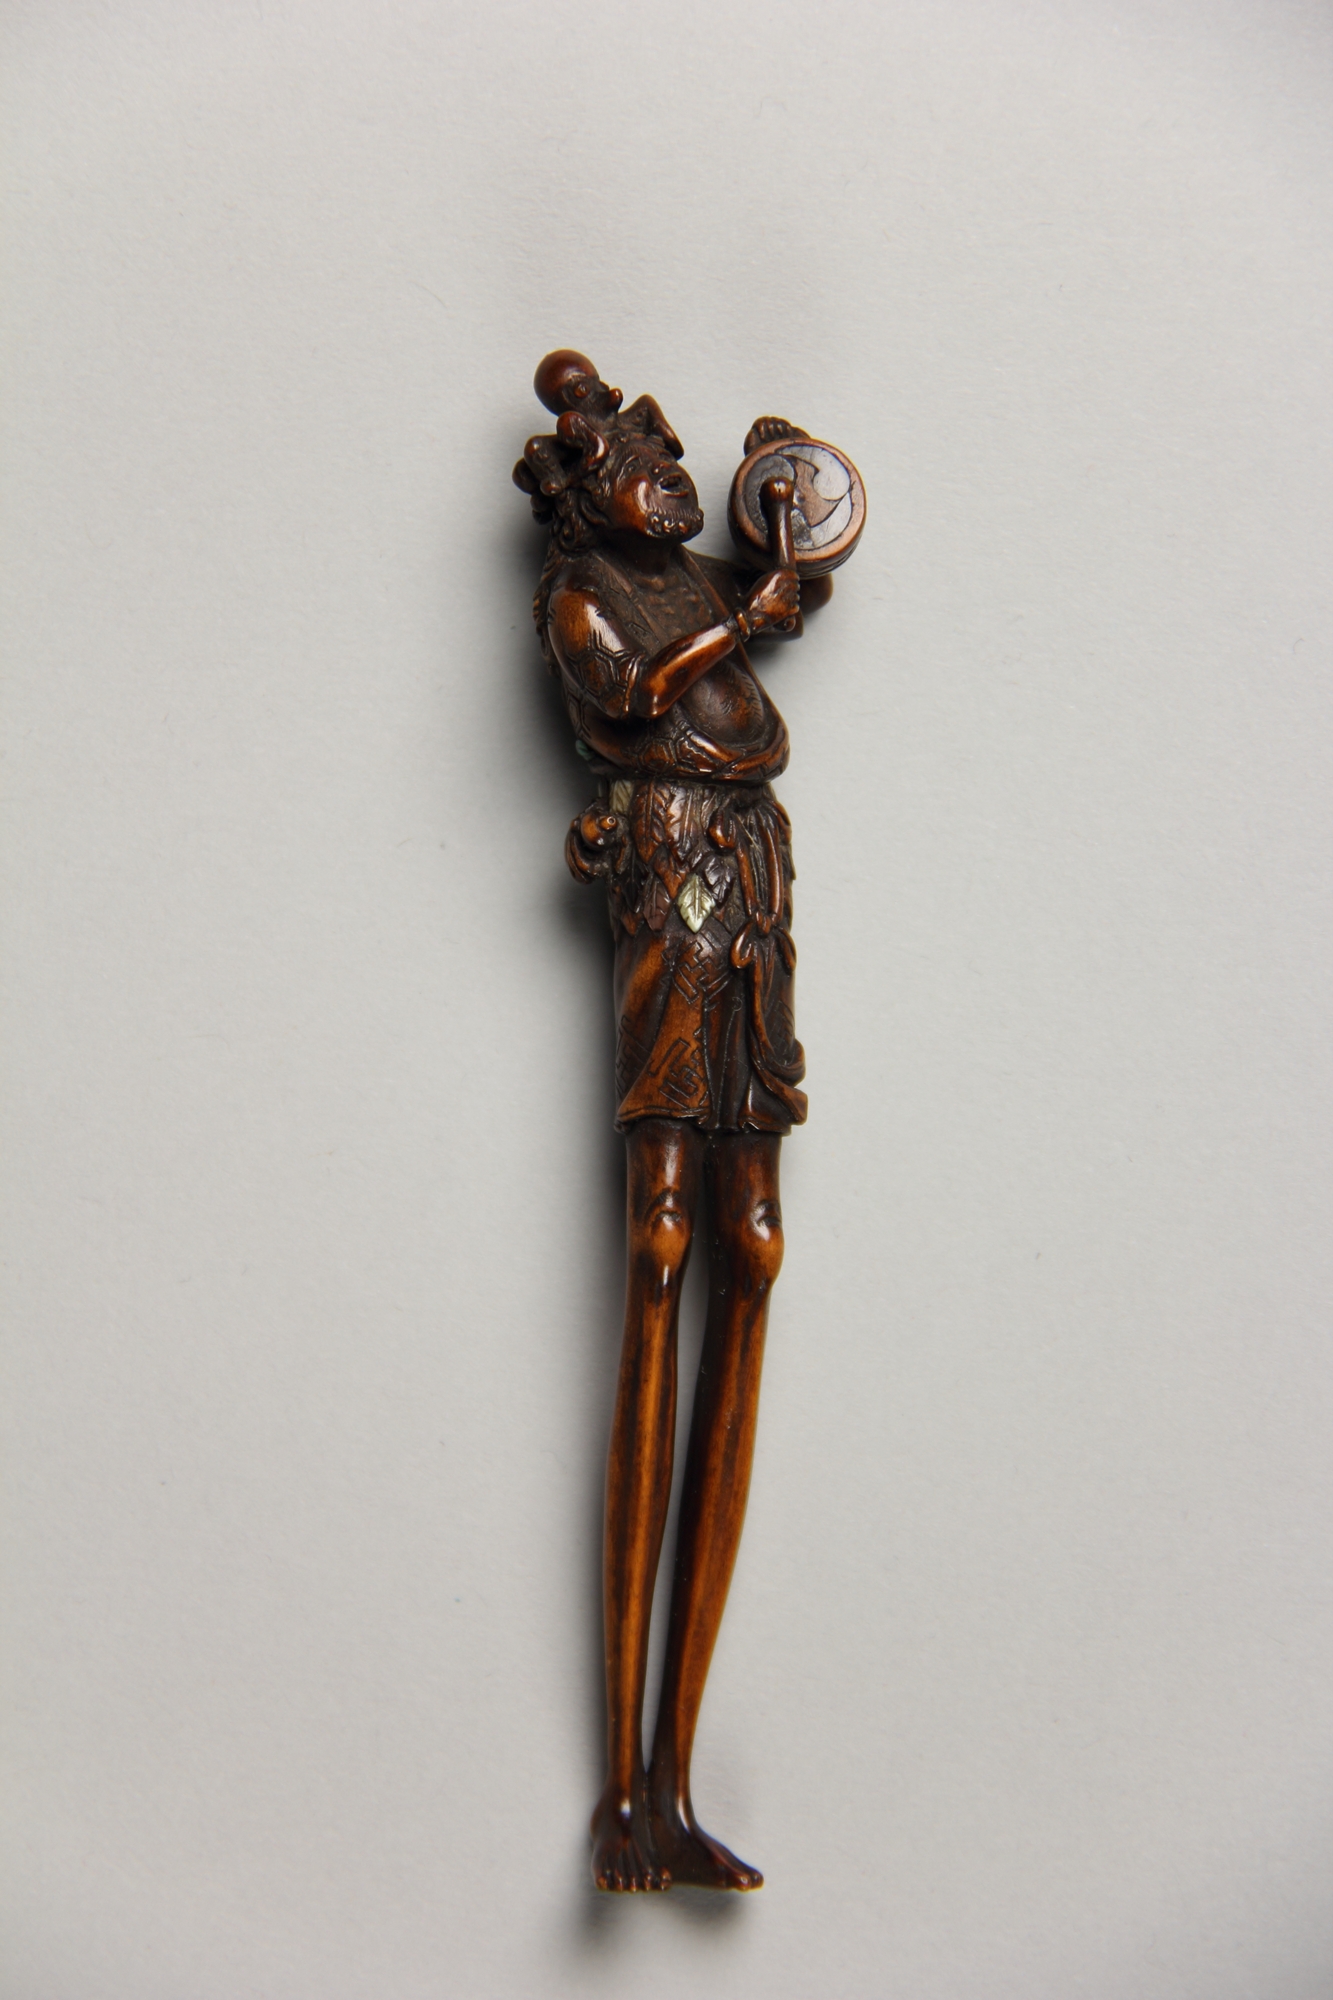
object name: netsuke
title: Netsuke of Ashinaga and Octopus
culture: japanese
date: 1801-1900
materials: ivory, wood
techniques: inlay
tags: men,fish